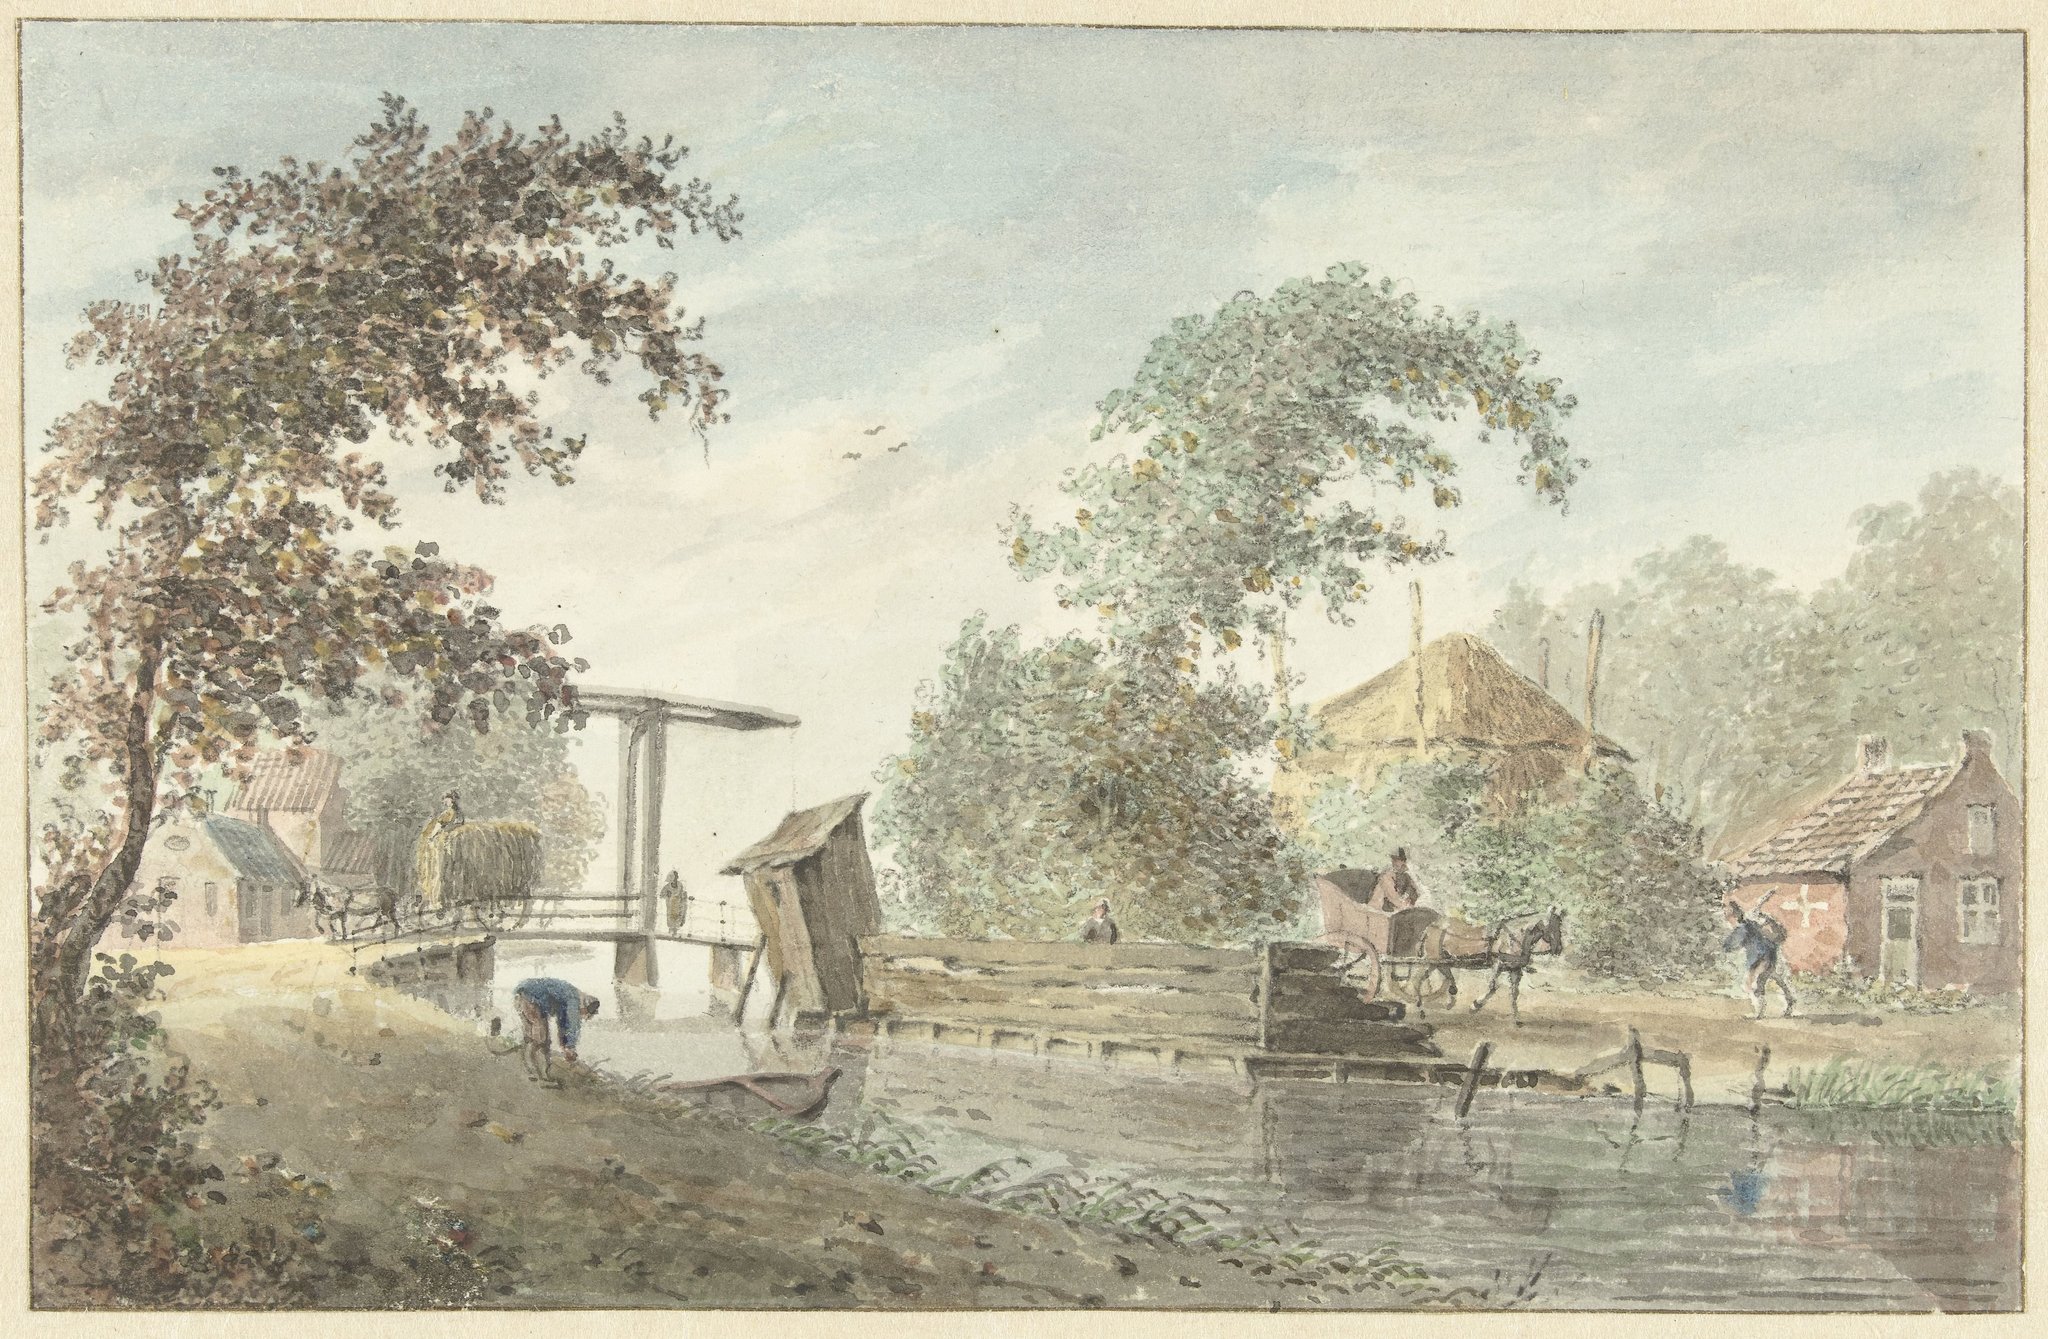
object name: watercolor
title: Boerderij aan een vaart met een ophaalbrug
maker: hermanus petrus schouten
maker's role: draughtsman, painter, print maker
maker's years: 1747-1822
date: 1757-1822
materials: paper, watercolor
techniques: brush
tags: small canal, ditch, farm or solitary house in landscape